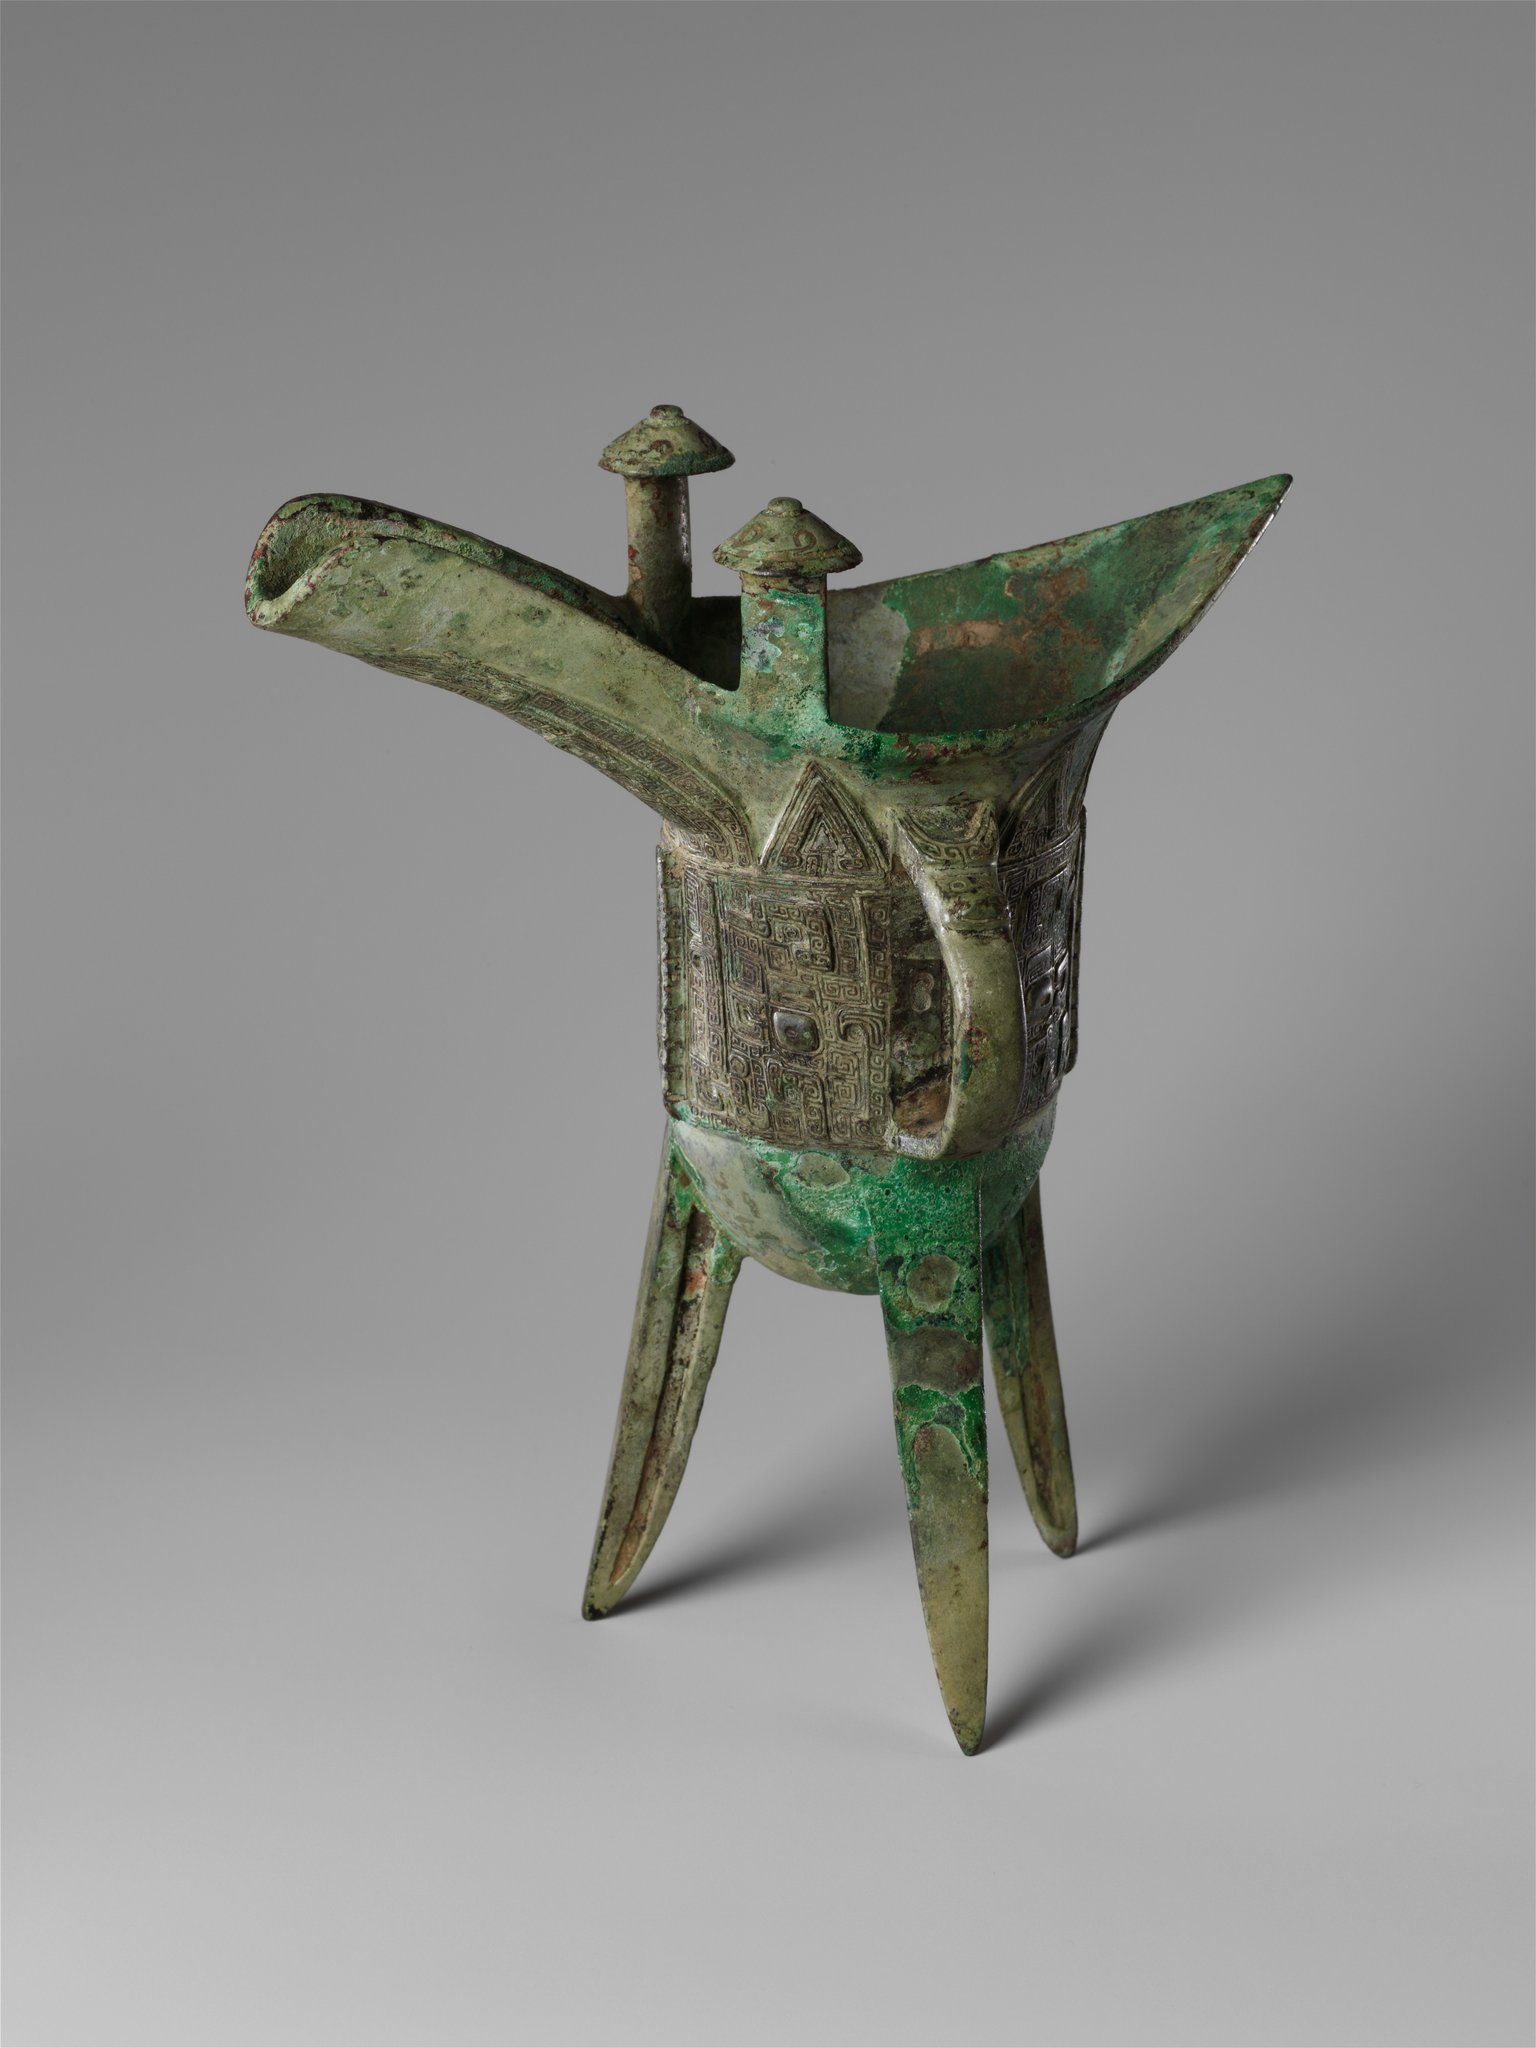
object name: wine warmer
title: Wine warmer (Jue)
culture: chinese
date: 1200-1101 BCE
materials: bronze